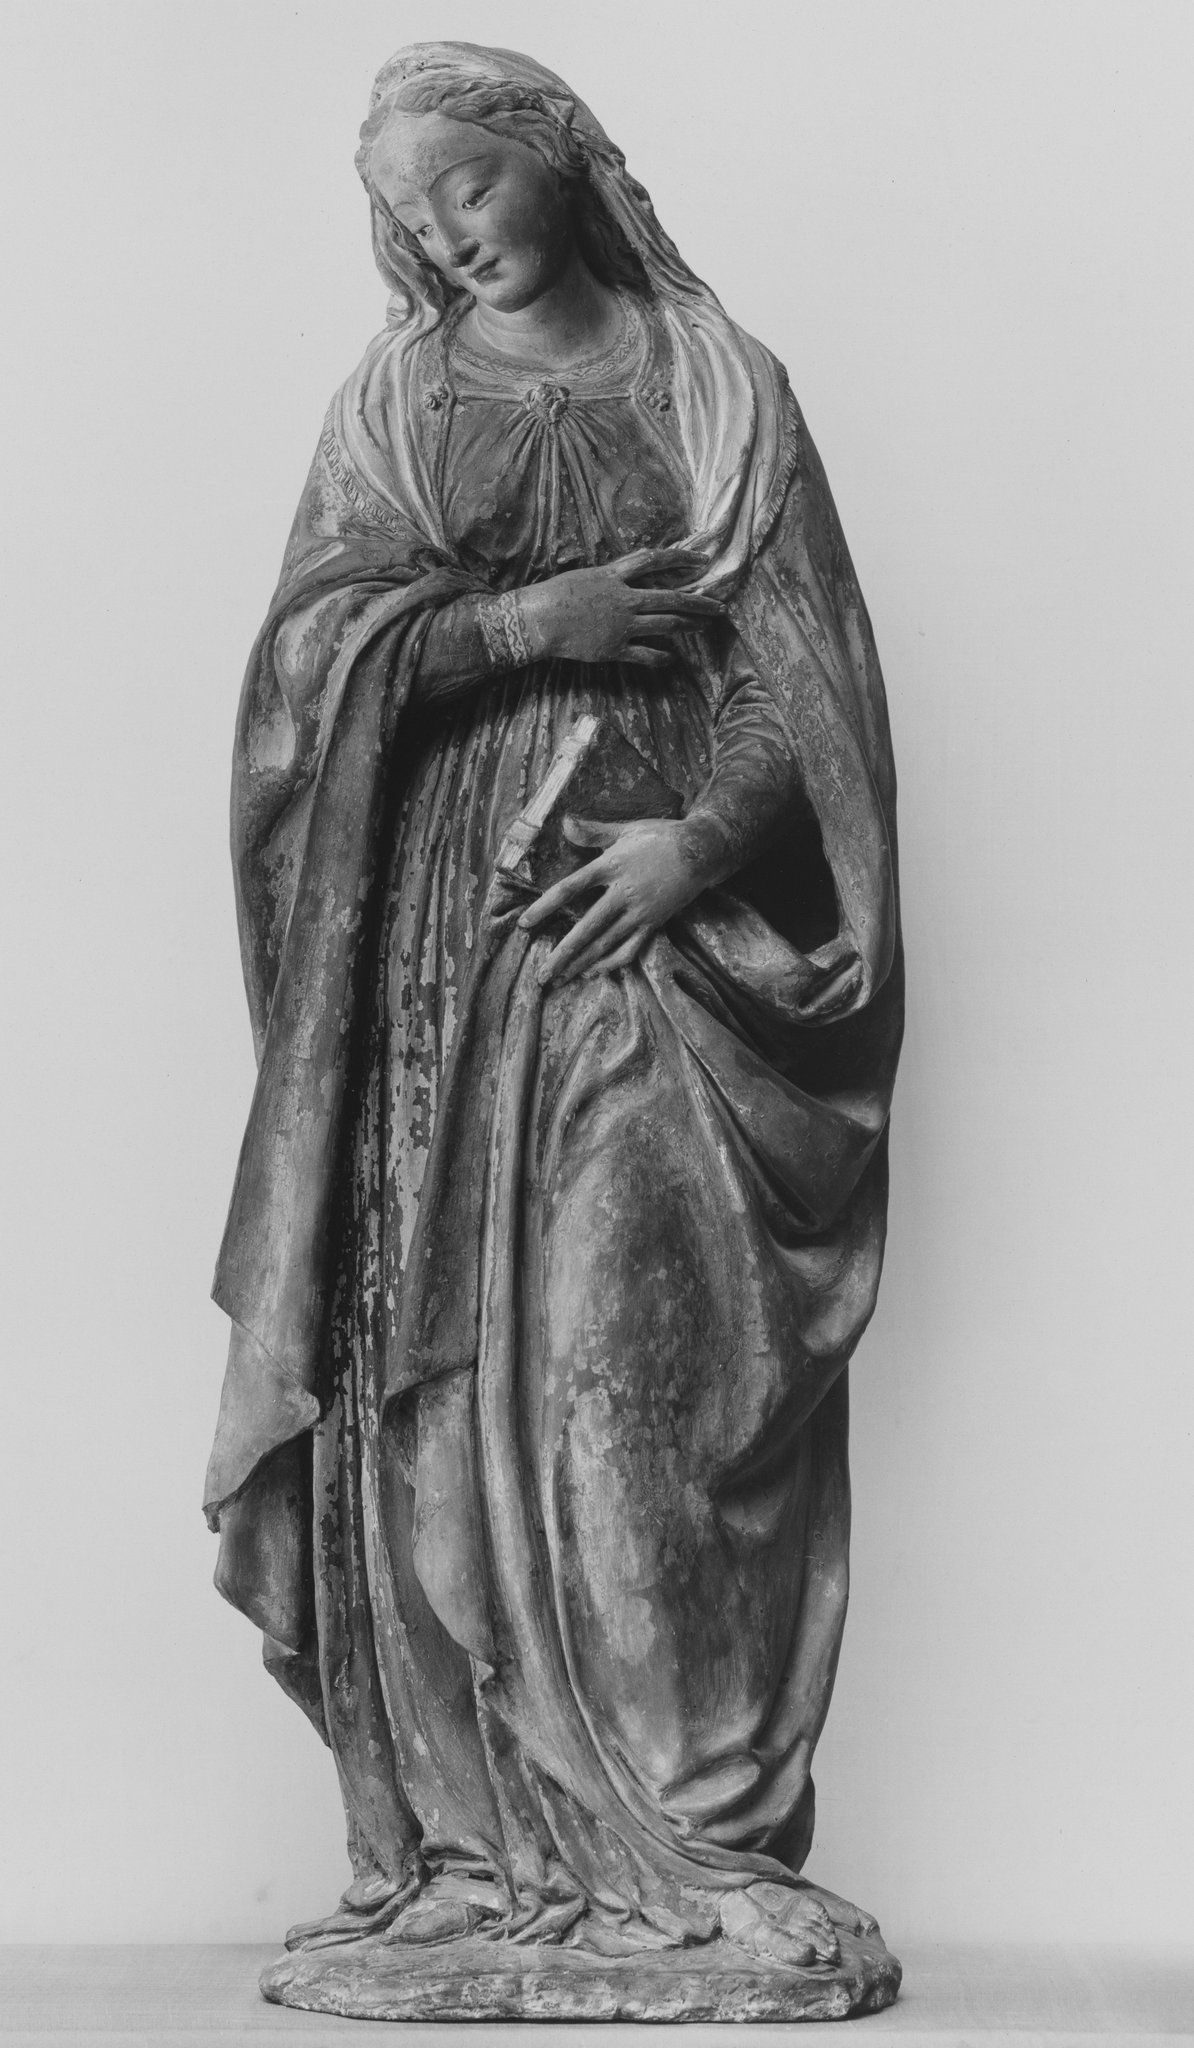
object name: statue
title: The Virgin Annunciate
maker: benedetto da maiano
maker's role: artist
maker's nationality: italian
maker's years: 1442-1497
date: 1467-1500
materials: terracotta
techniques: painting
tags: virgin mary